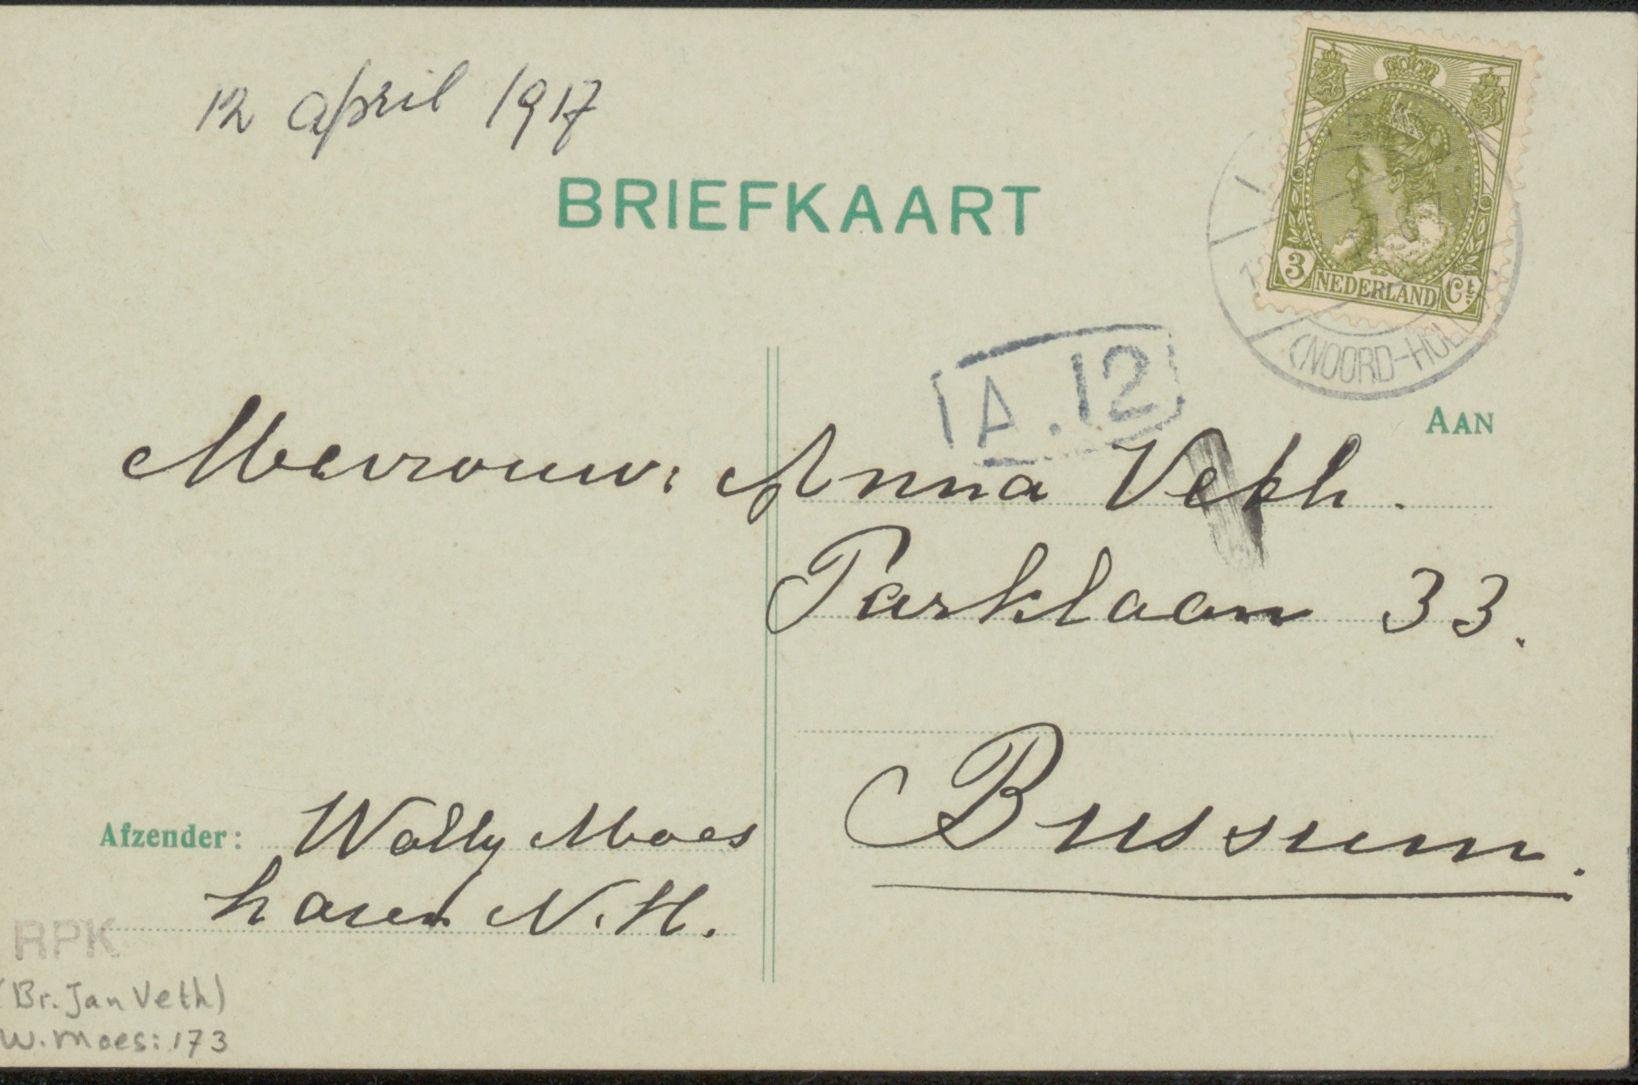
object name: postcard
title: Briefkaart aan Anna Dorothea Dirks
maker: wally moes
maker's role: draughtsman, print maker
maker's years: 1856-1918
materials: cardboard, pencil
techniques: writing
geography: laren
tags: artist, anna dorothea dirks, drawing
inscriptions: collector's mark: ‘RPK’